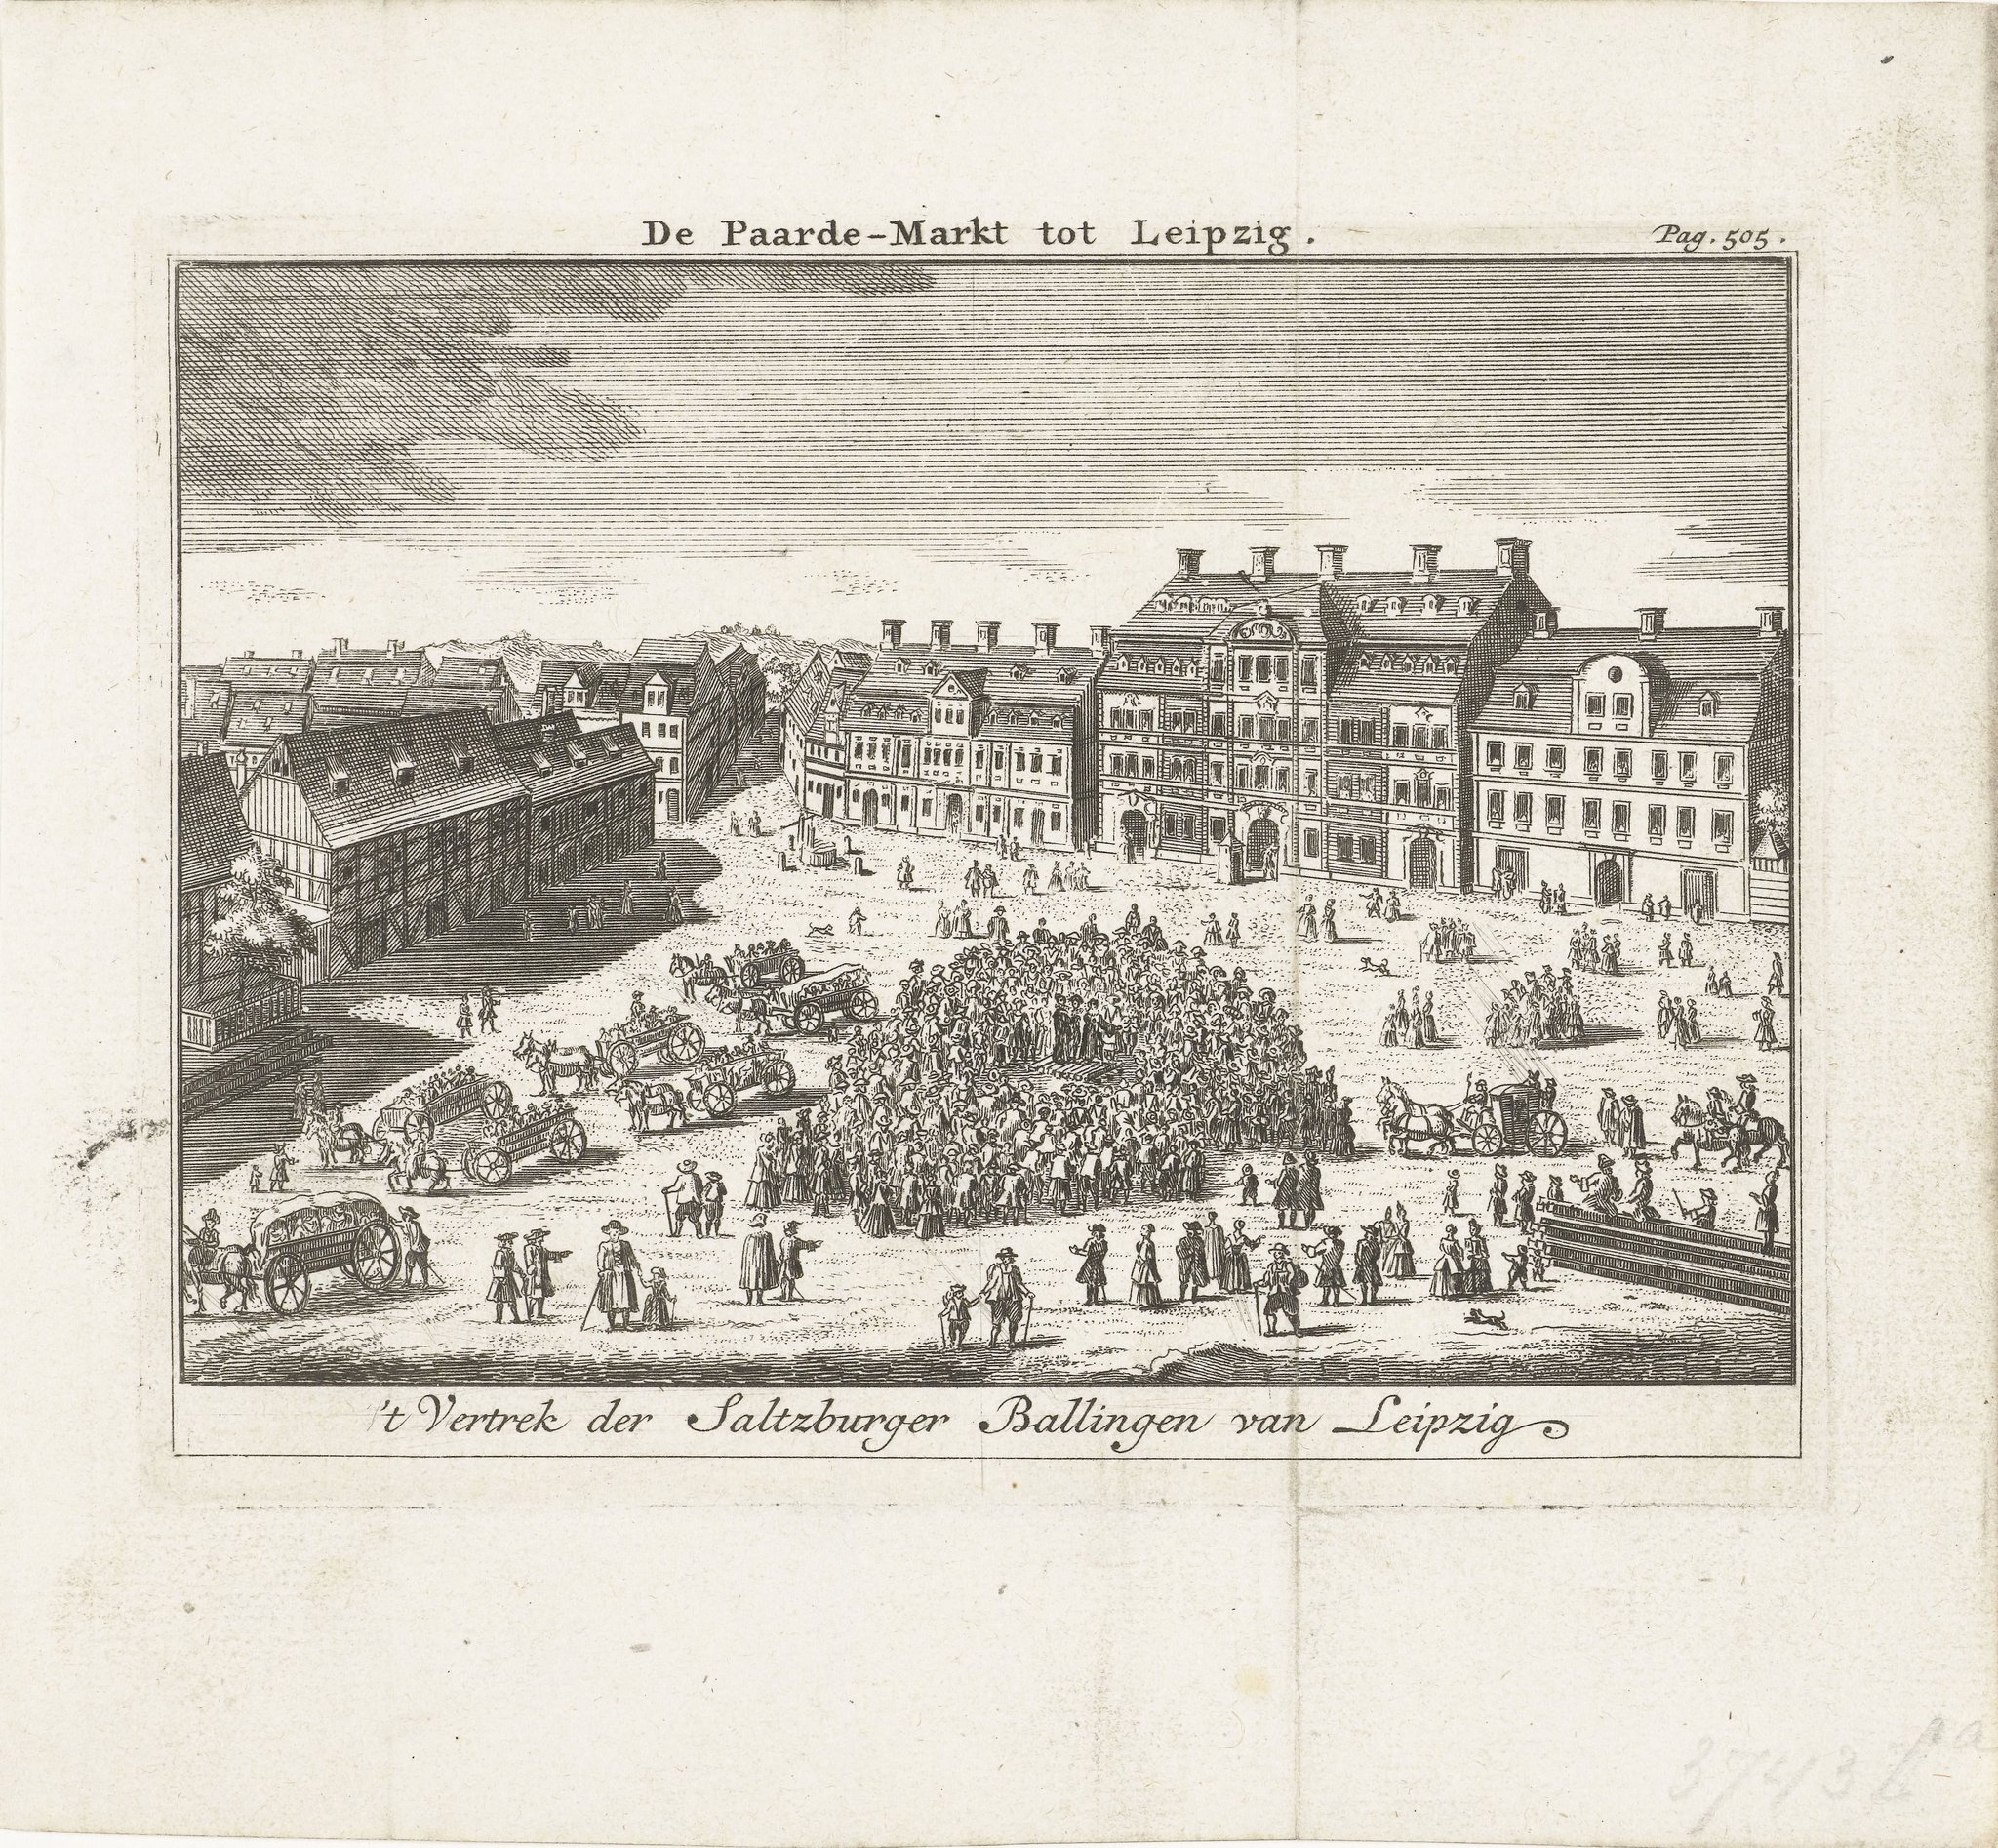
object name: print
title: Salzburgse emigranten verzameld te Leipzig om naar Nederland te vertrekken, 1732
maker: Anonymous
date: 1732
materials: paper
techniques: etching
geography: northern netherlands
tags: persecuted believers (hiding), e.g. huguenots, pilgrim fathers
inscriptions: collector's mark: Lugt 2228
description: Gezicht op de Paardenmarkt te Leipzig waar een groep uitgeweken lutherse Salzburgse emigranten is verzameld om naar Nederland te vertrekken, 1732. Gemerkt rechtsboven: Pag. 505.